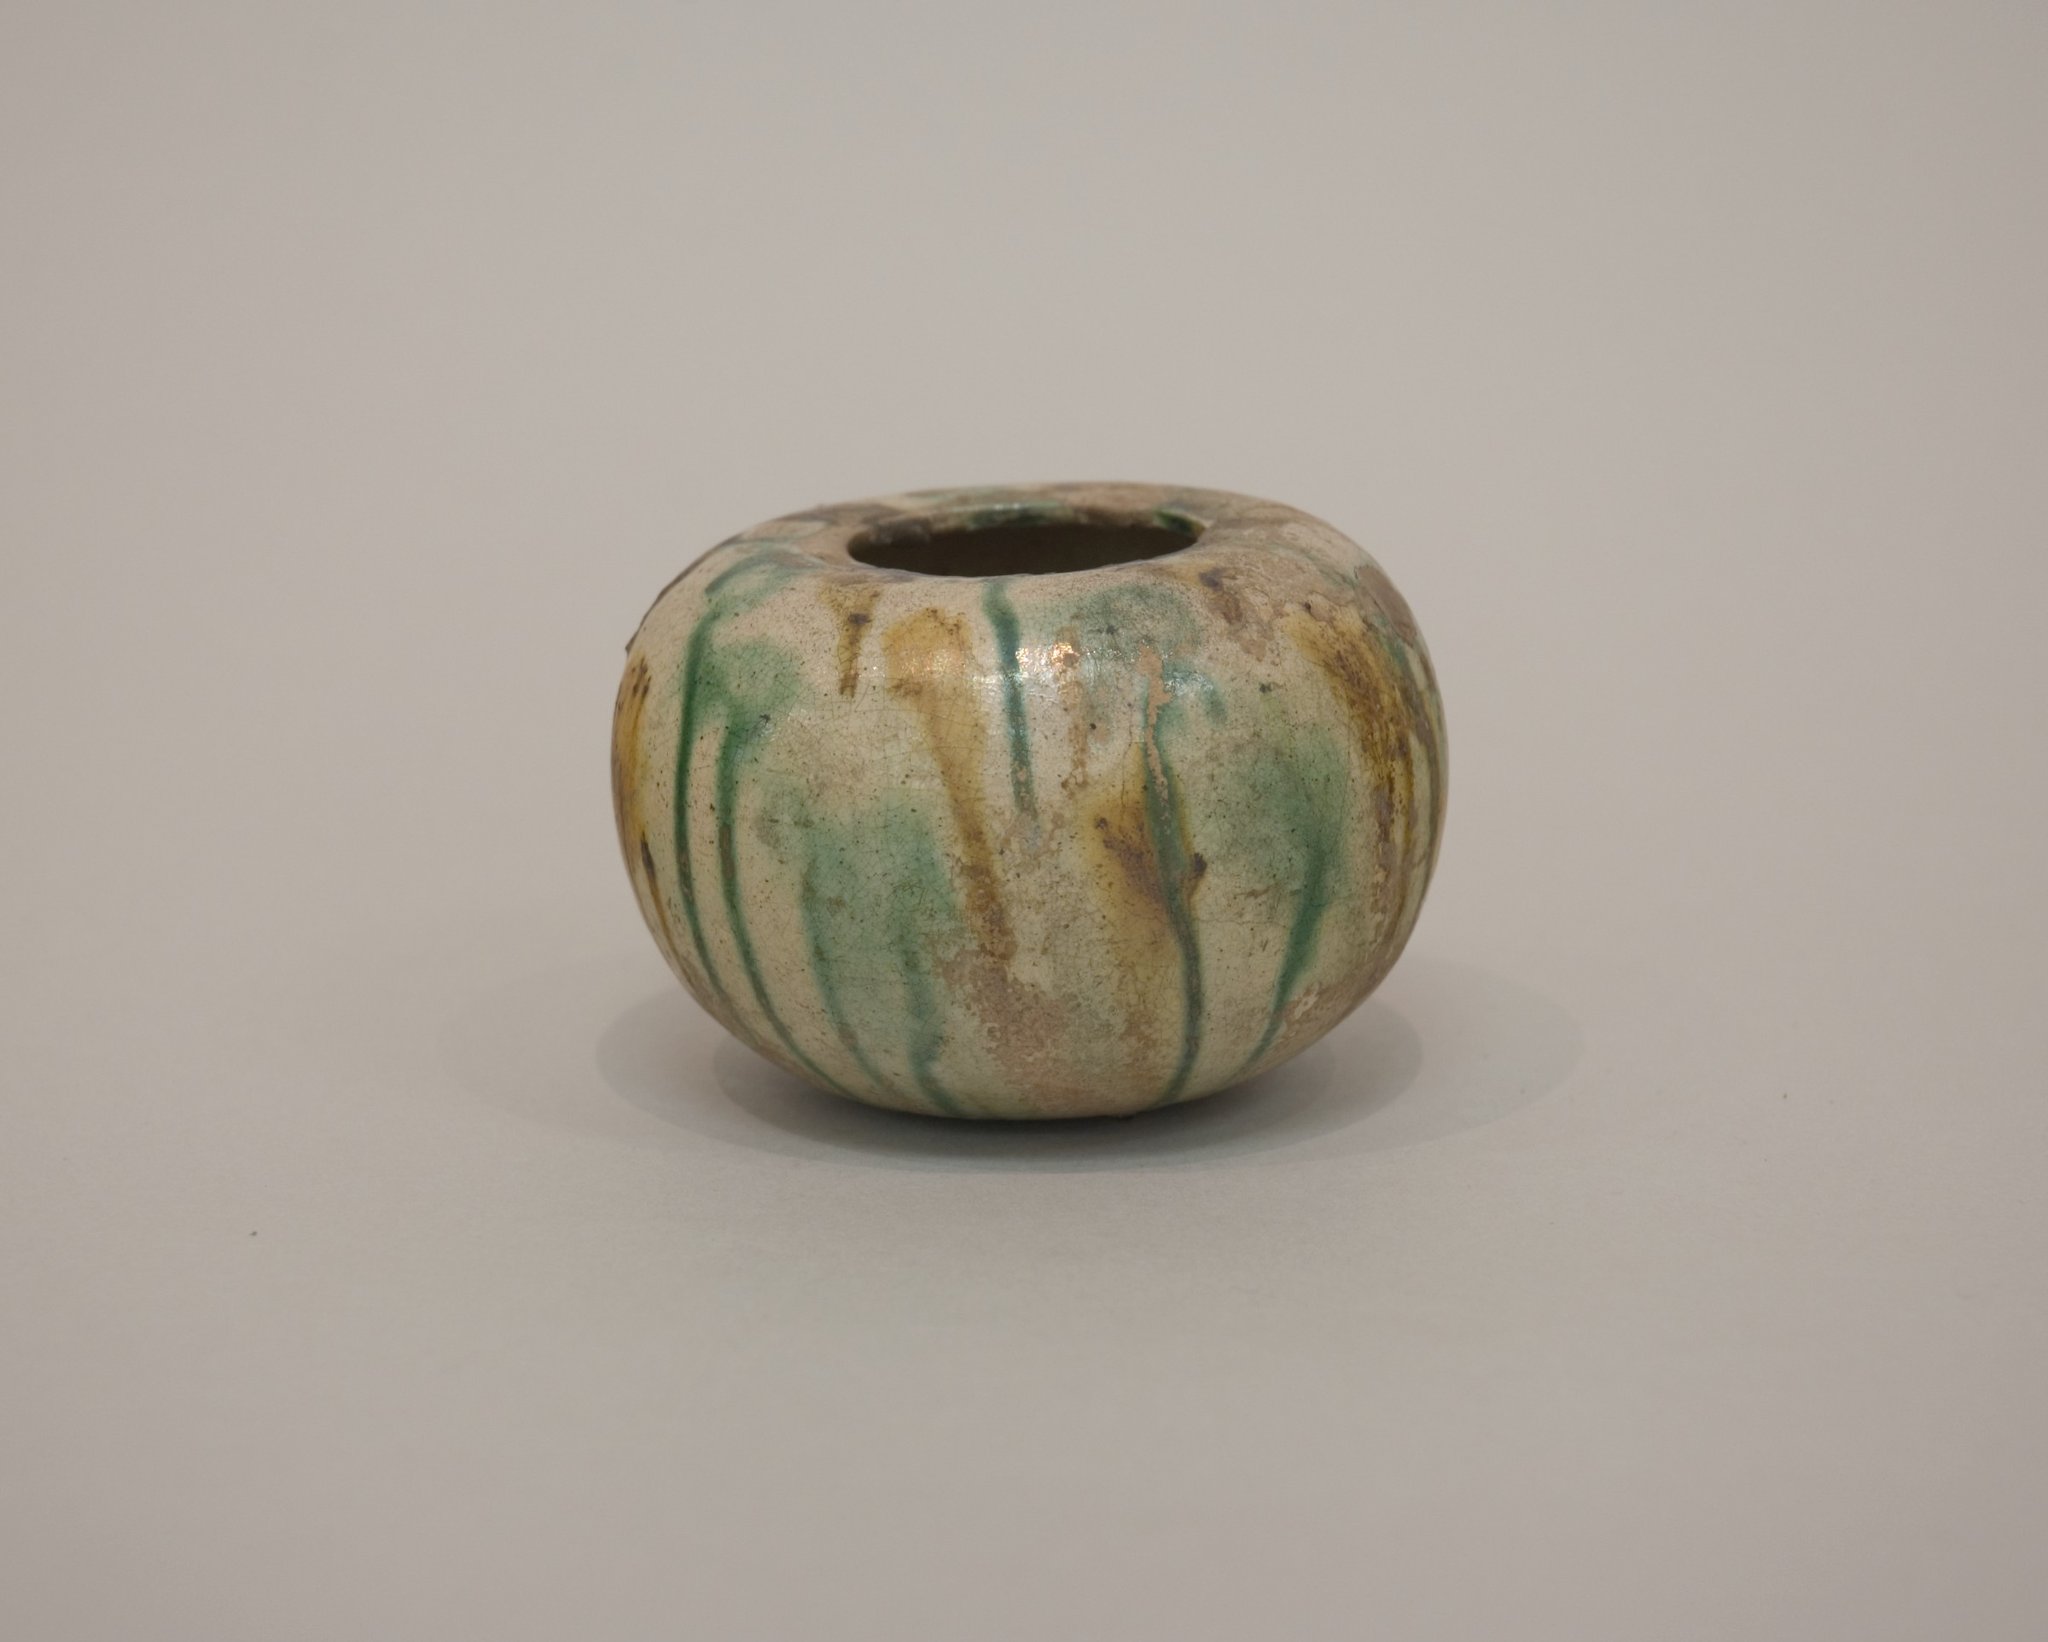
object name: bowl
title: Miniature alms bowl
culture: chinese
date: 701-800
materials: earthenware, glaze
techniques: polychrome